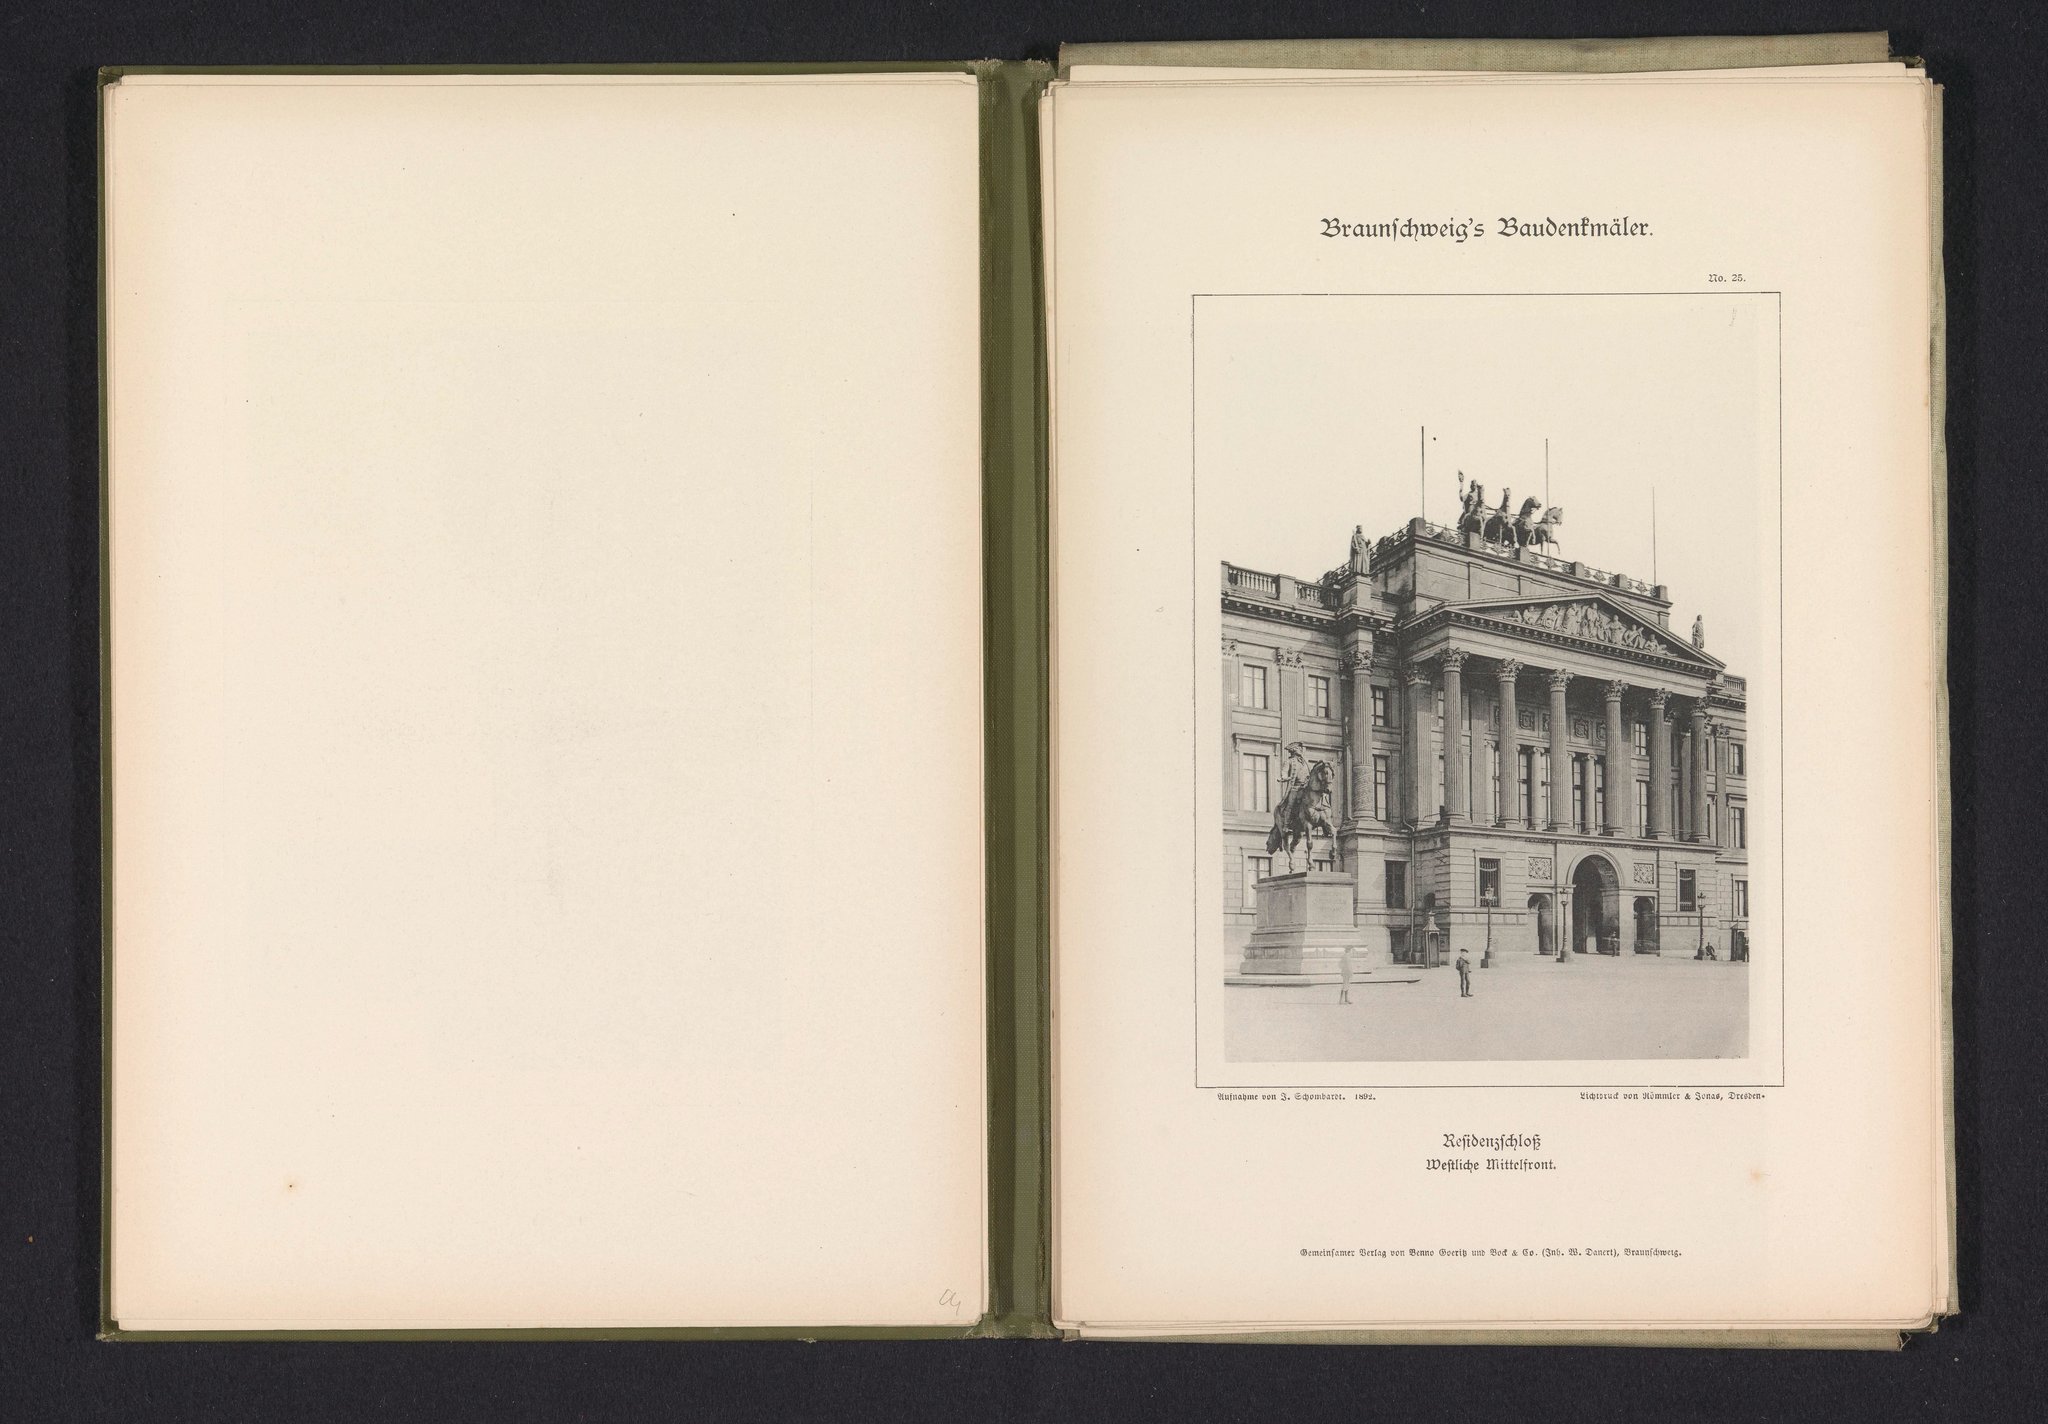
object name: photomechanical print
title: Braunschweig's Baudenkmäler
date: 1892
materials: paper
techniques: photograph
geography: braunschweig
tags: palace, façade (of house or building)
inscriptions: number: ‘No. 25.’